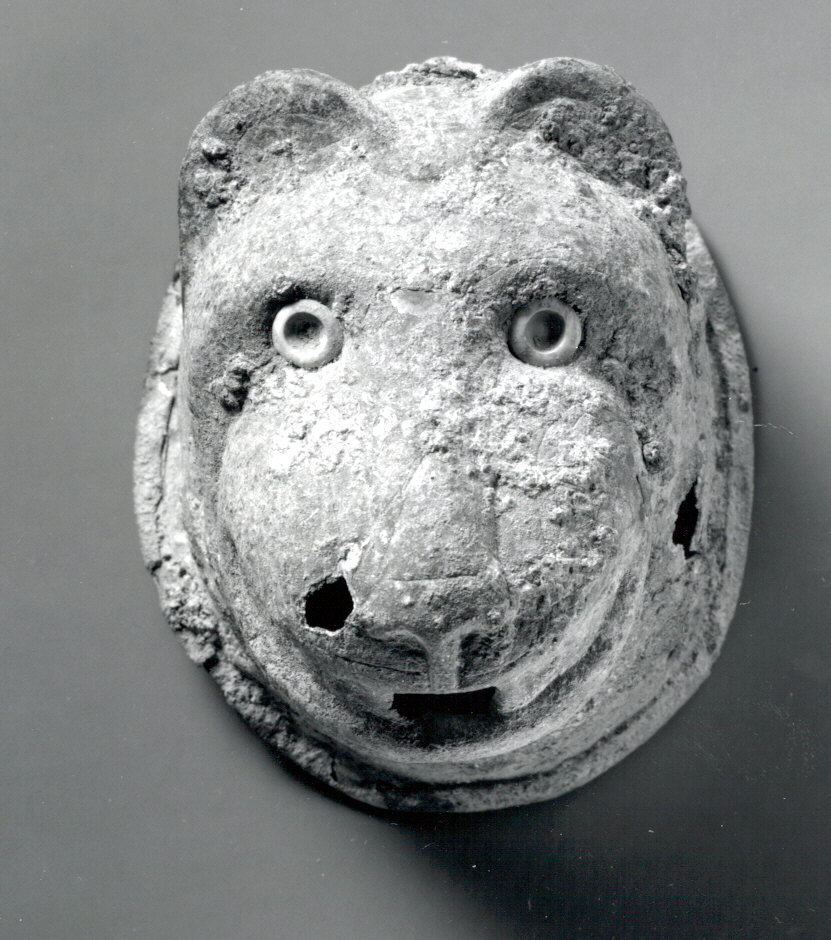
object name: sculpture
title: Head of a lion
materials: copper alloy, shell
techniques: inlay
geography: mesopotamia or syria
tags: lions